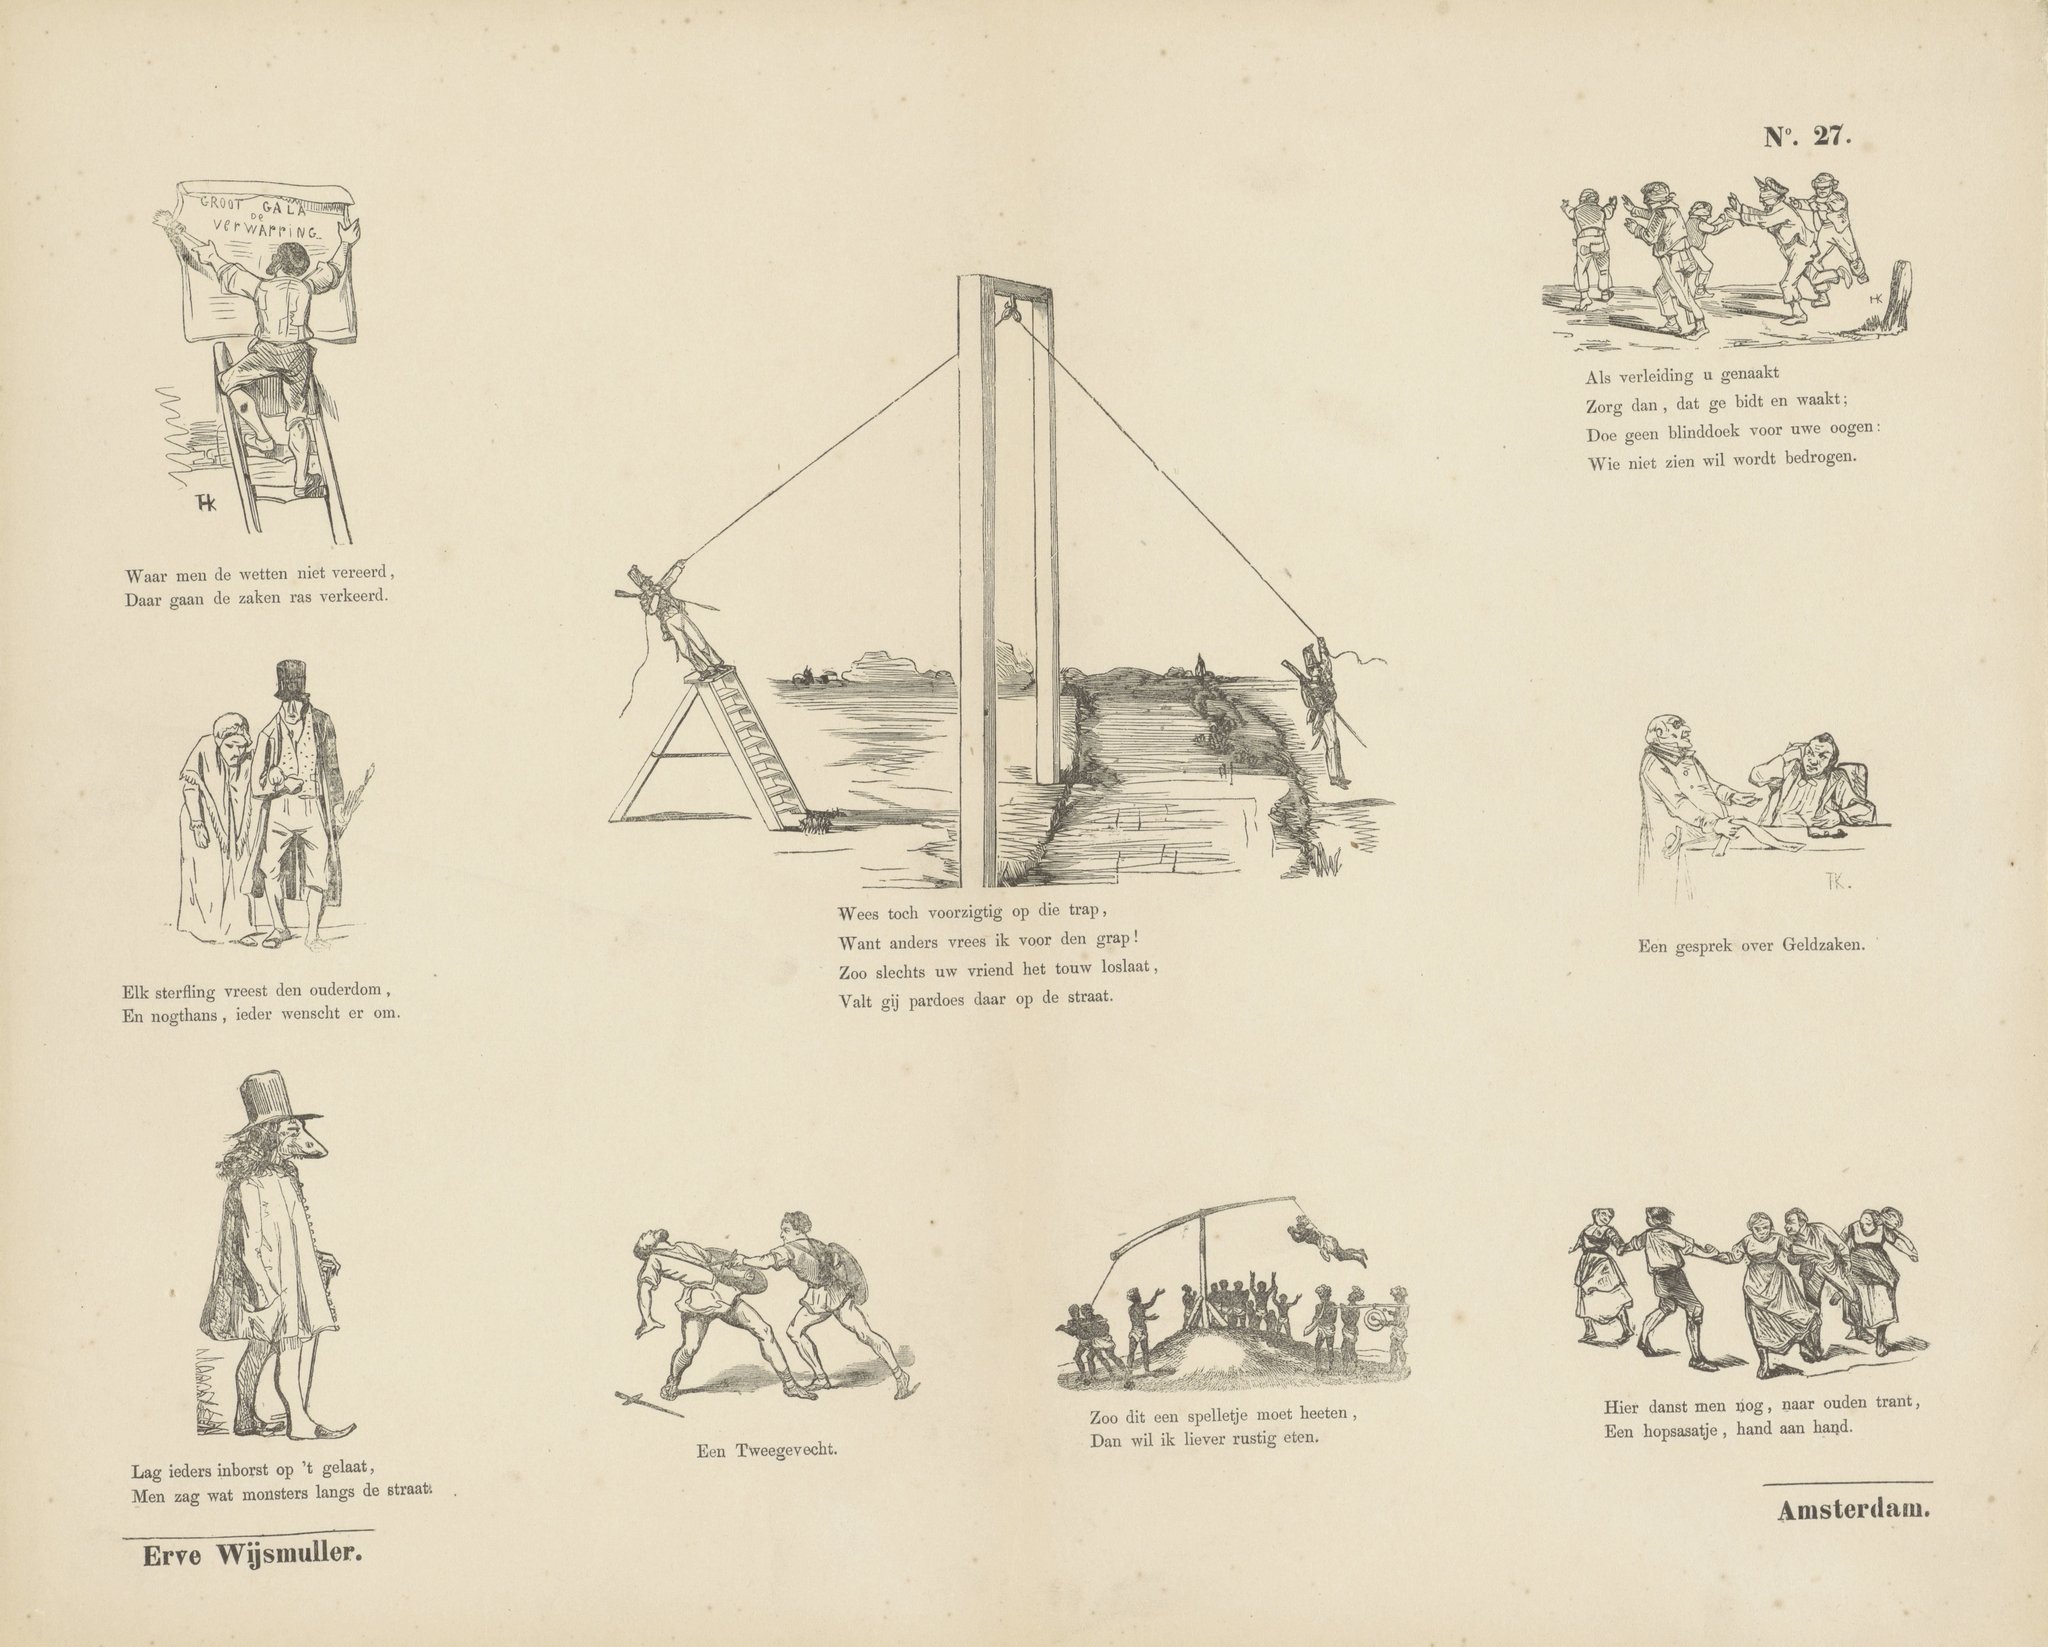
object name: popular print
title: Verschillende voorstellingen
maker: Anonymous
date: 1828-1913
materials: paper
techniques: letterpress printing, line block, engraving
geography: netherlands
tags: characters (human types), group dancing, fighting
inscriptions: collector's mark: Lugt 2760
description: Blad met 9 voorstellingen van verschillende aard, waaronder een ouder paar, een tweegevecht, dansende mensen en een gesprek over geldzaken. Onder elke afbeelding een onderschrift. Onder de eerste afbeelding het onderschrift: Waar men de wetten niet vereerd, / Daar gaan de zaken ras verkeerd. Genummerd rechtsboven: No. 27.